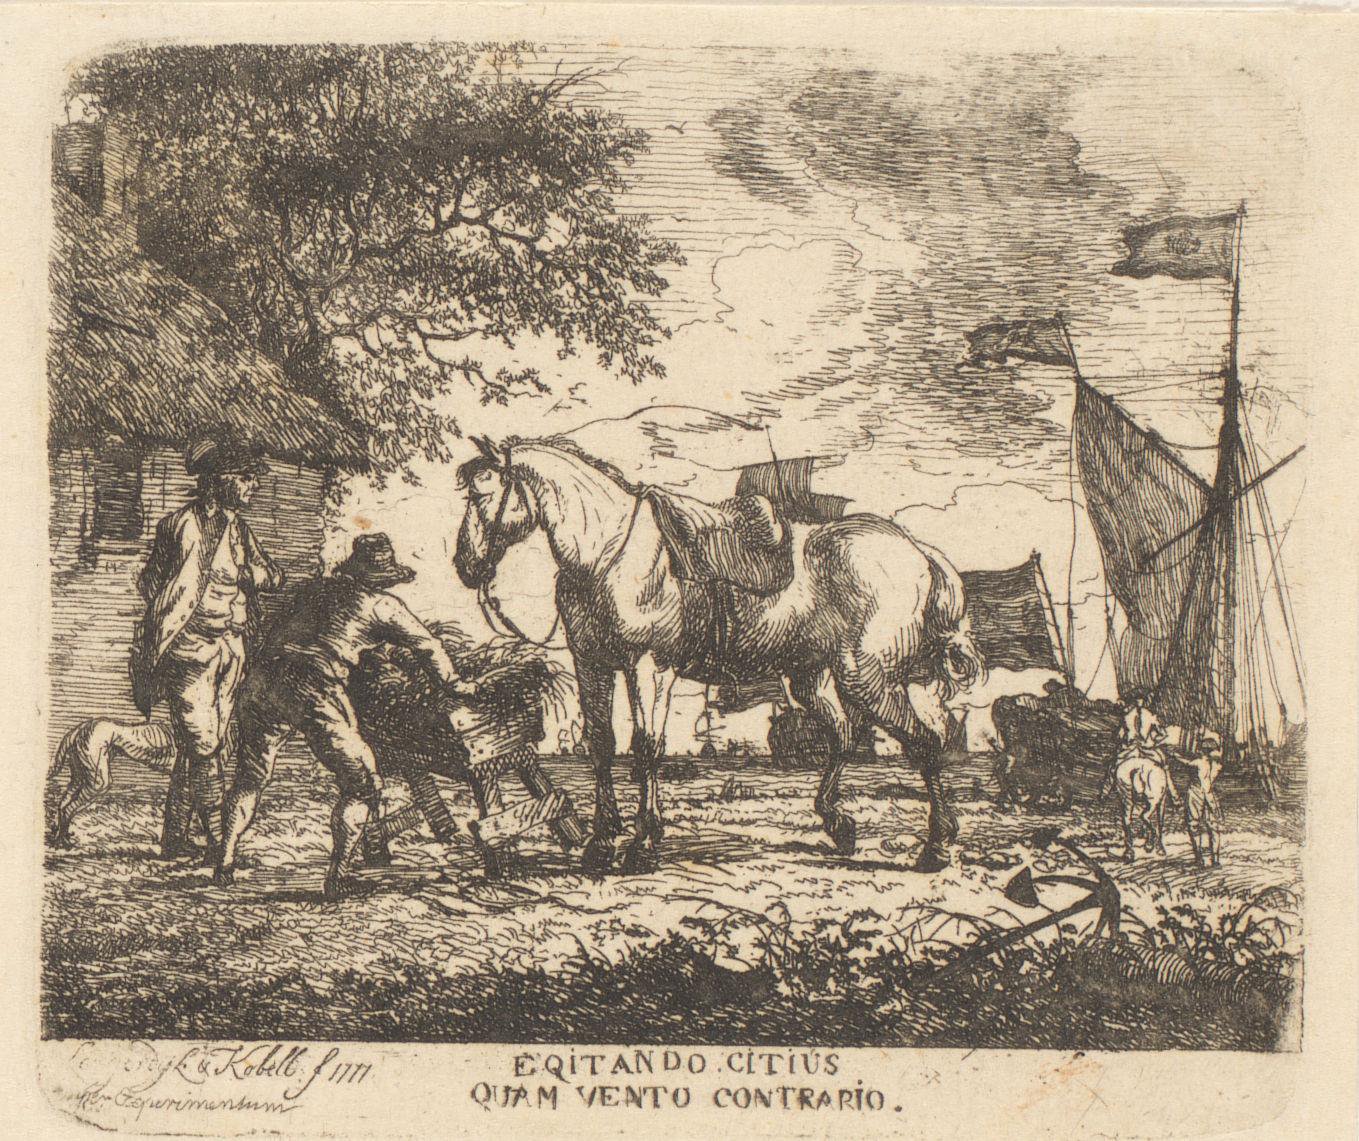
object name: print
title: Voeren van het paard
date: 1777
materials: paper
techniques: etching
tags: sailing-ship, sailing-boat, the soldier; the soldier's life, horse, dog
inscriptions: collector's mark: Lugt 2228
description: Bij een boerderij zet een man een kribbe gevuld met hooi voor een gezadeld paard neer. Een soldaat kijkt in het gezelschap van een hond toe. Op de achtergrond zijn een soldaat te paard en verschillende schepen afgebeeld, rechts op de voorgrond ligt een anker.